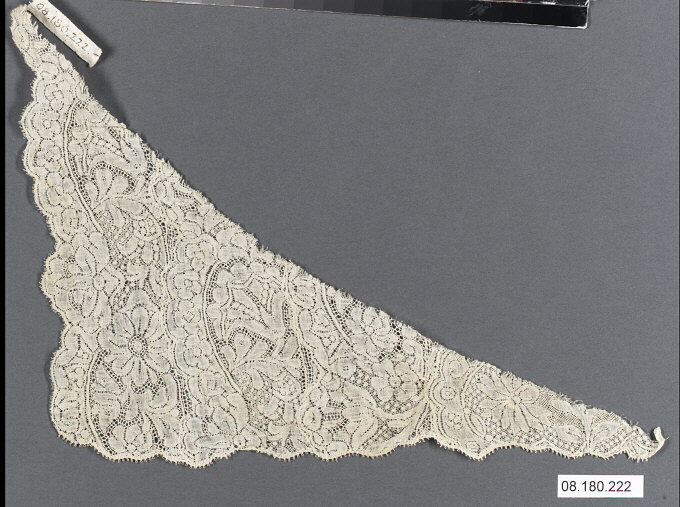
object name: fragment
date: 1701-1733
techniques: lace